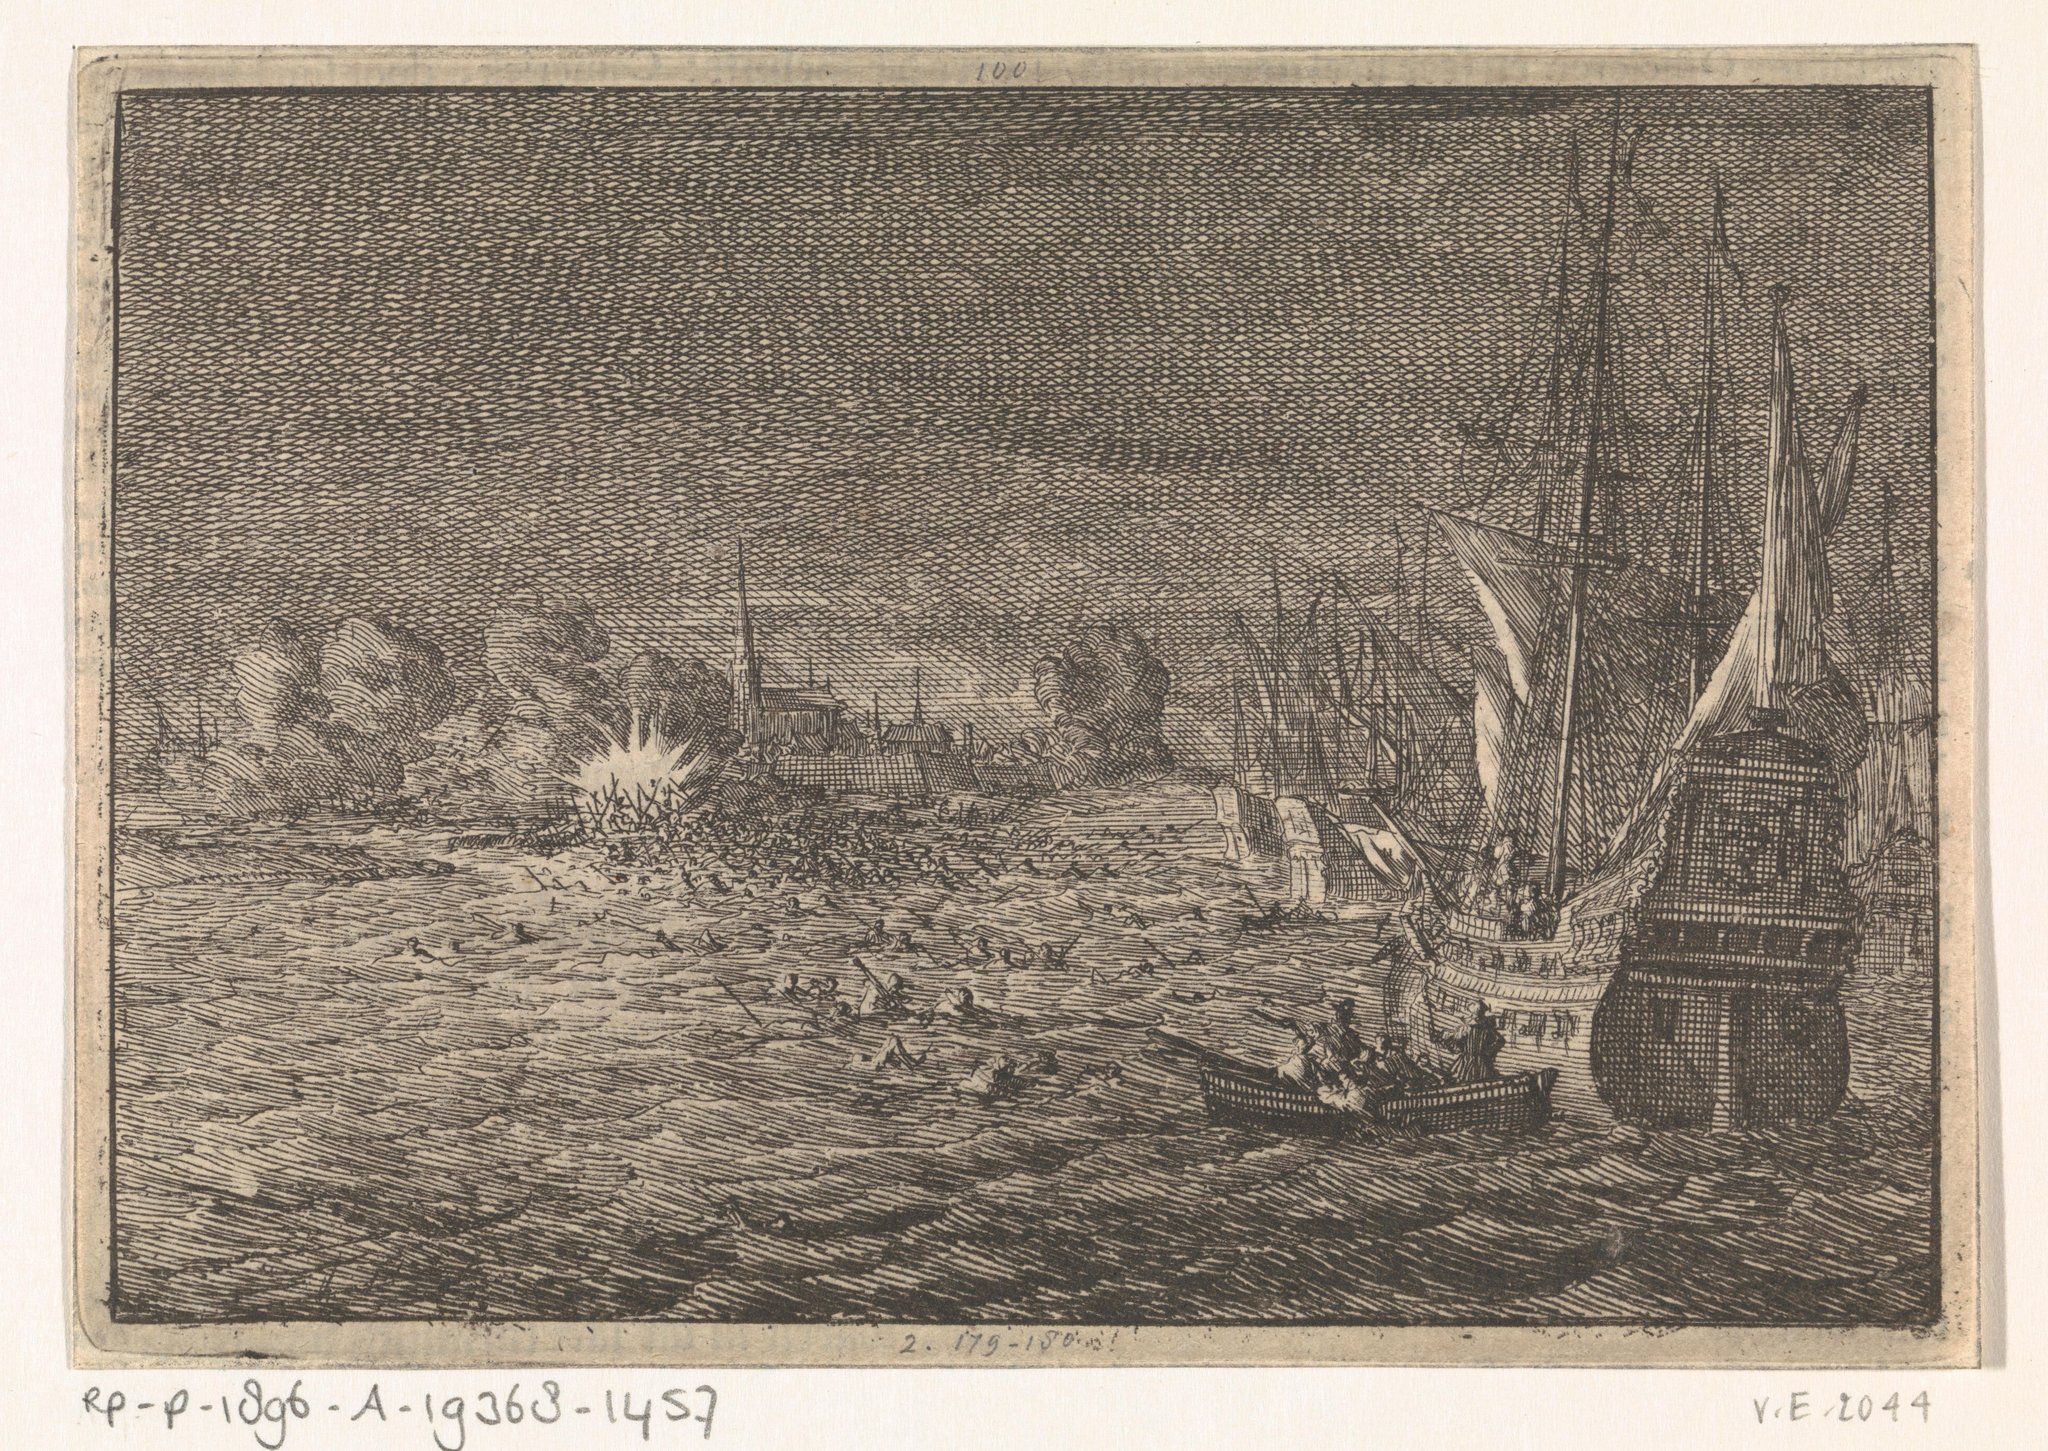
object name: book illustration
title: Oostende door de Spanjaarden veroverd op de Fransen, 1658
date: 1698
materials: paper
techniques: etching, letterpress printing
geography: amsterdam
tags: attack ~ siege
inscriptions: collector's mark: Lugt 2228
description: Illustratie uit: Gottfried, Johann Ludwig. Historische kronyck; vervattende een (...) beschrijvingh der aldergedenckwaerdigste geschiedenissen des weerelds, van den aenvangh der scheppingh tot (...) 1576 (2 delen). Leiden: Pieter van der Aa, 1698, dl. II, p. 179.